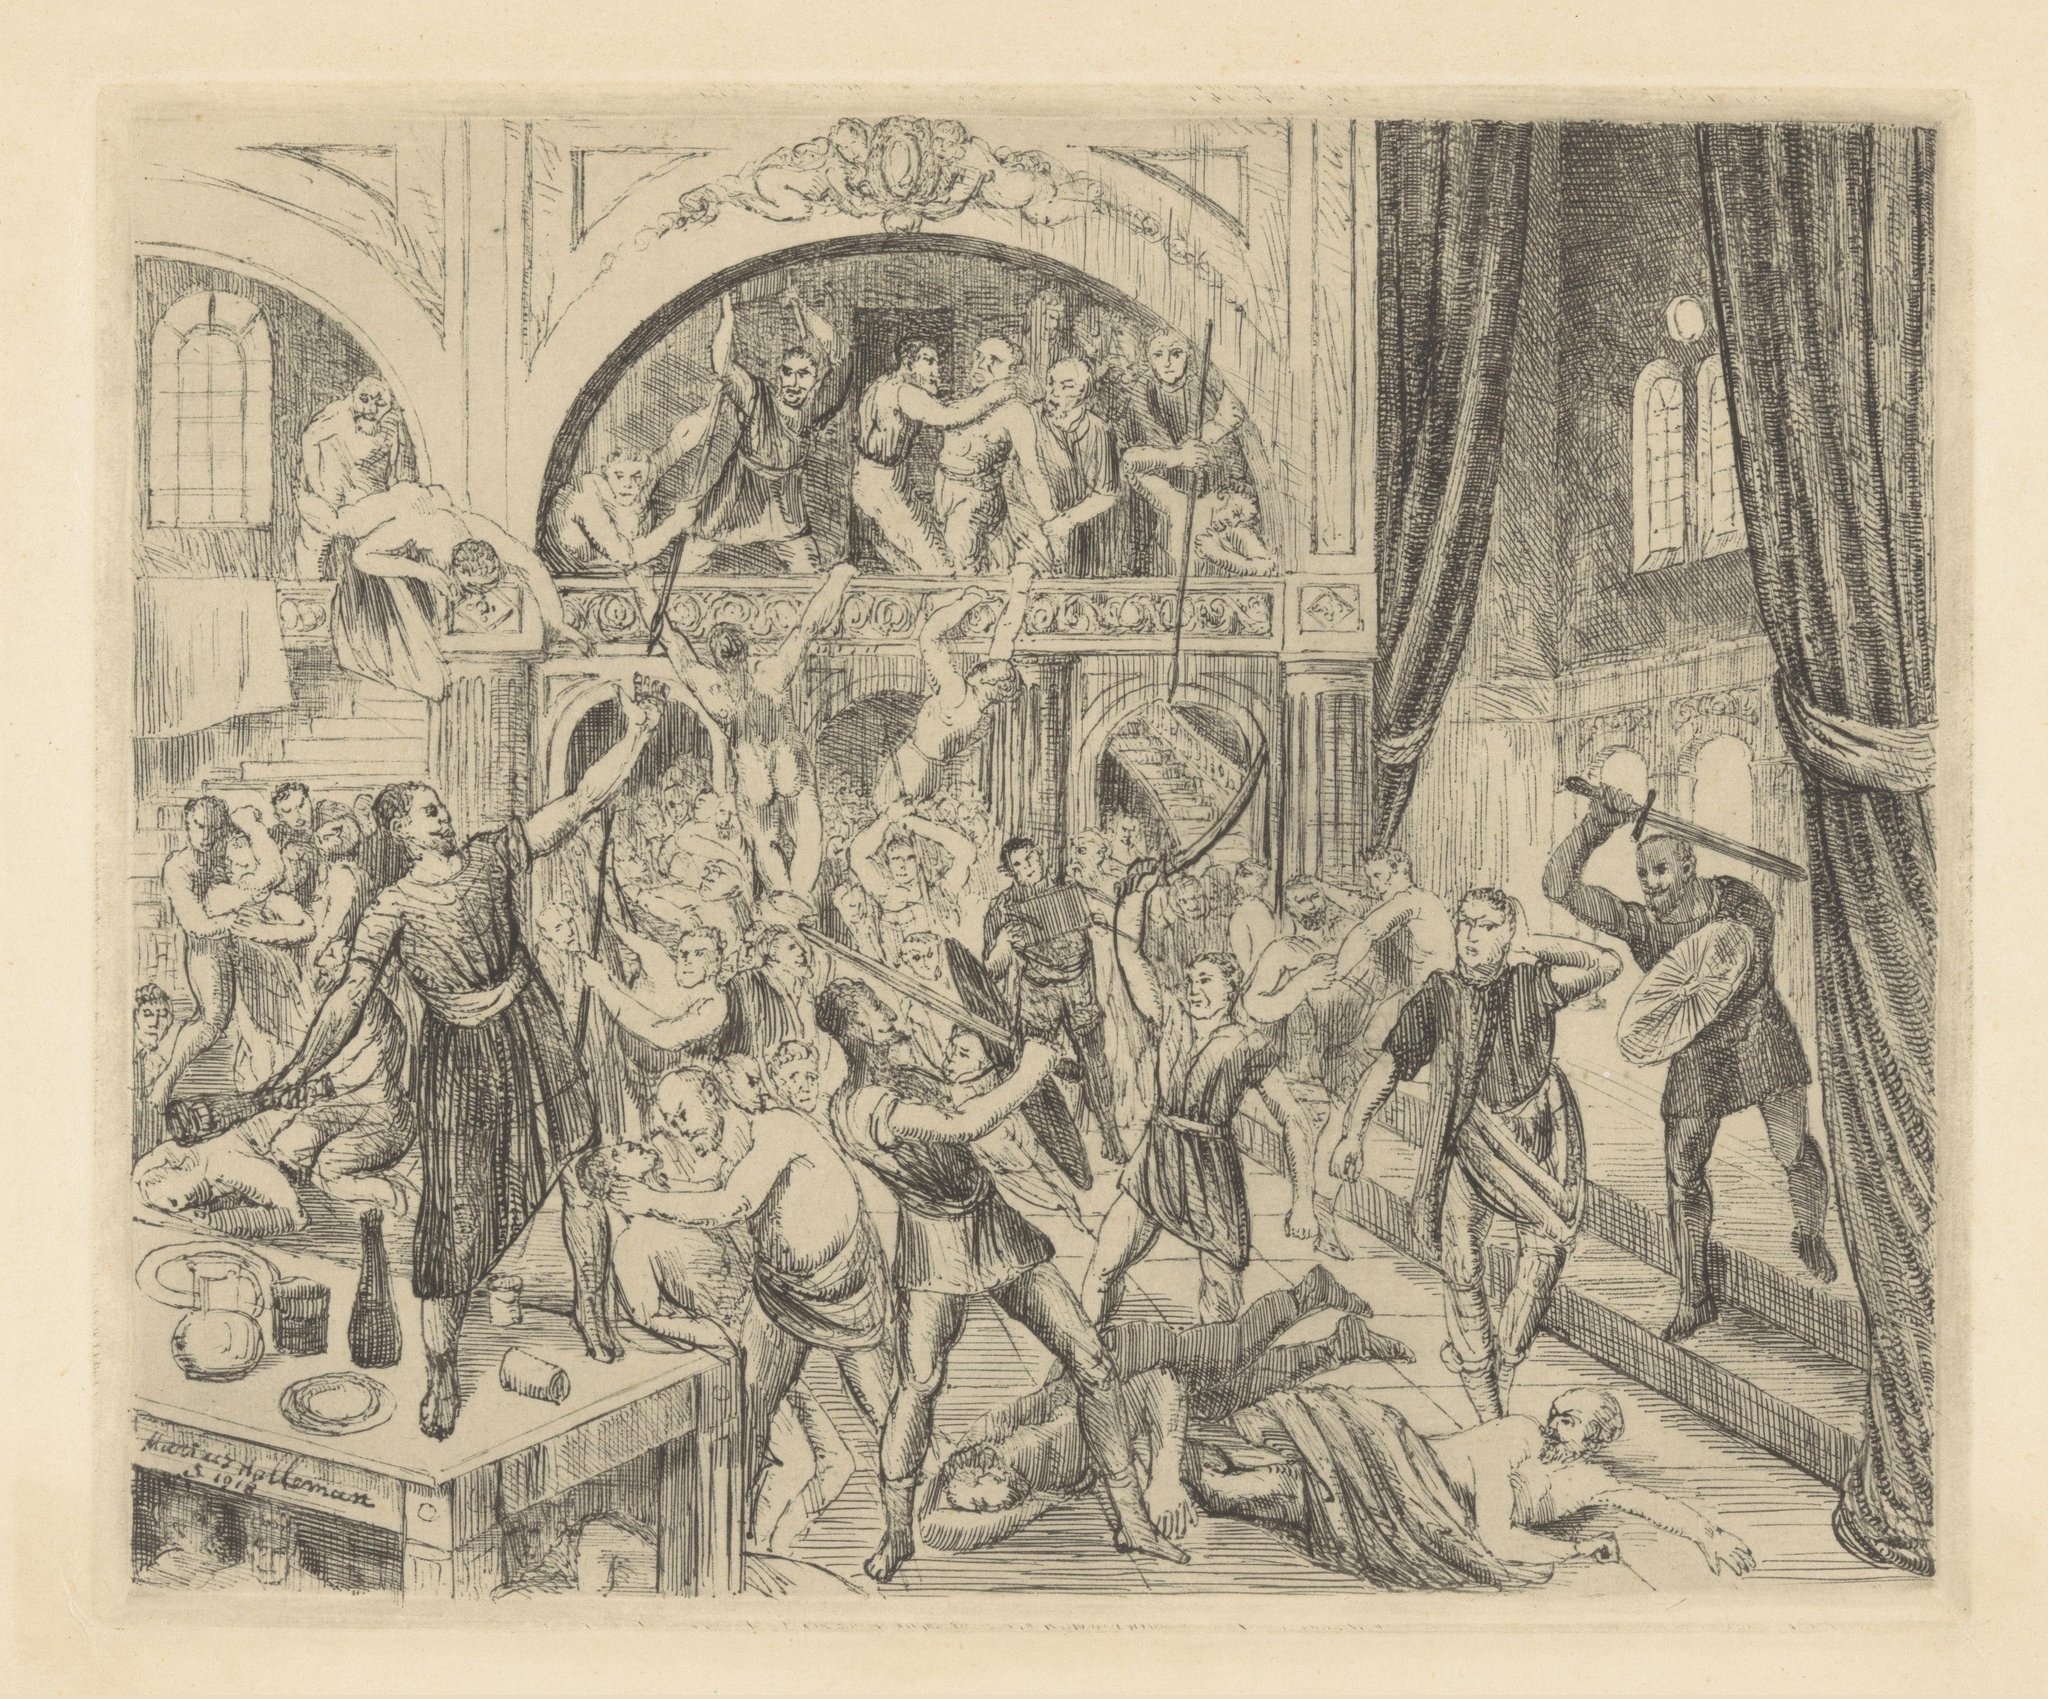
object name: print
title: Odysseus doodt de vrijers van Penelope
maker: marius holleman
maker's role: draughtsman, print maker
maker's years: 1878-1926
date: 1918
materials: paper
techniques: etching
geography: groningen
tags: ulysses, assisted by telemachus, kills the suitors (homer, odyssey xxii)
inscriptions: collector's mark: Lugt 2228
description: Op de voorgrond vechten mannen met zwaarden. Links op de tafel staat een man op het punt een fles te gooien. Op de achtergrond hangen mannen aan een balustrade.